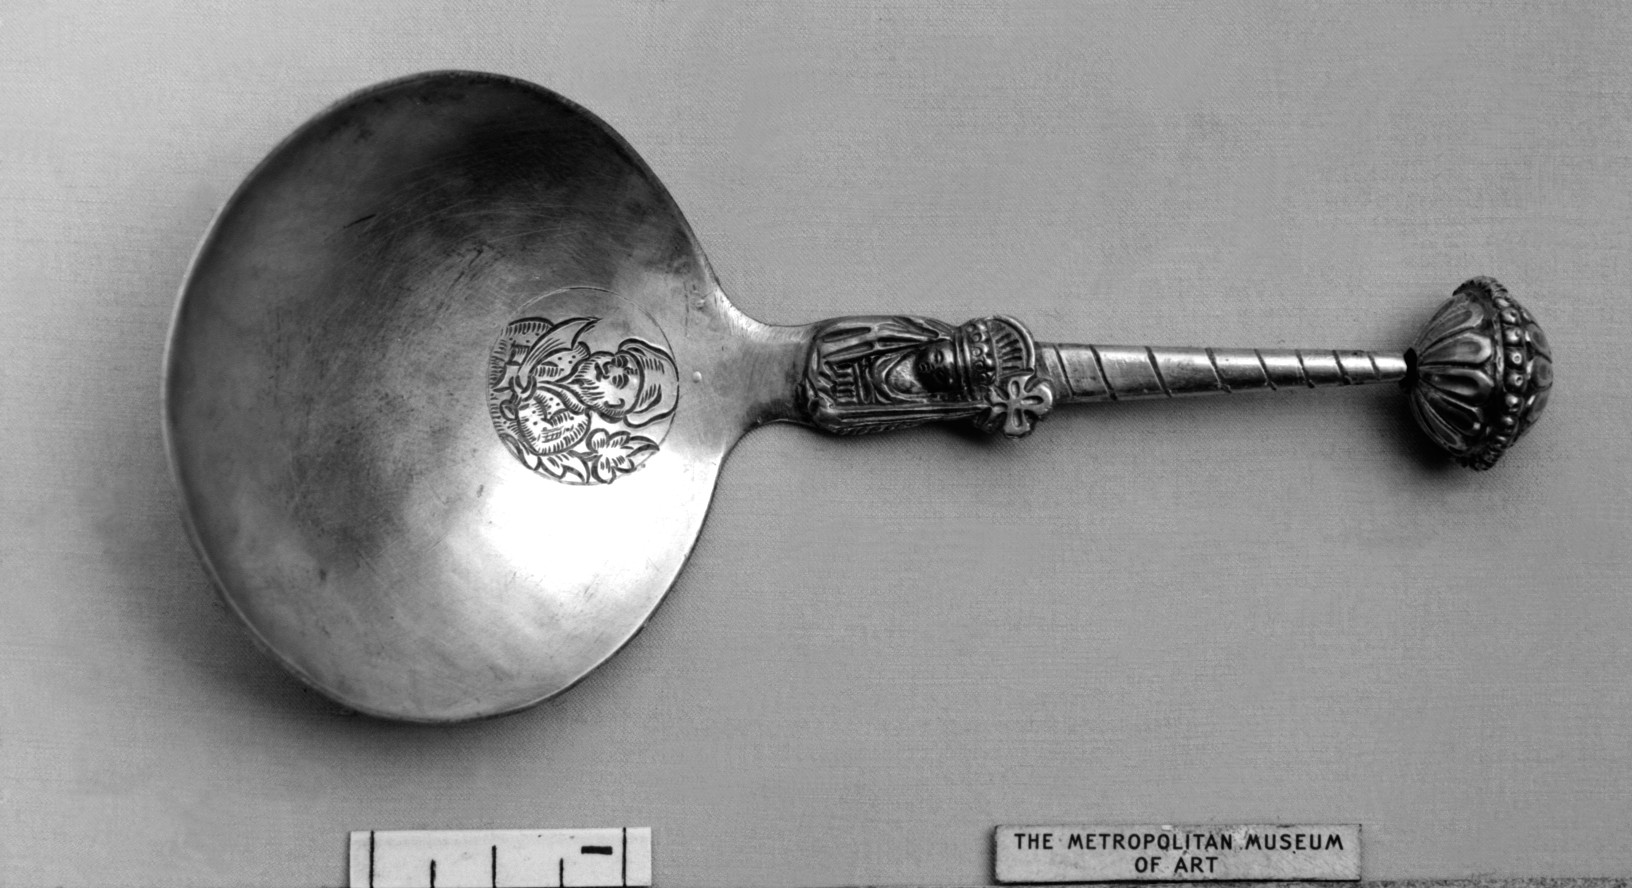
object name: spoon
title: Ball-topped spoon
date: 1801-1900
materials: gilt, silver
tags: men